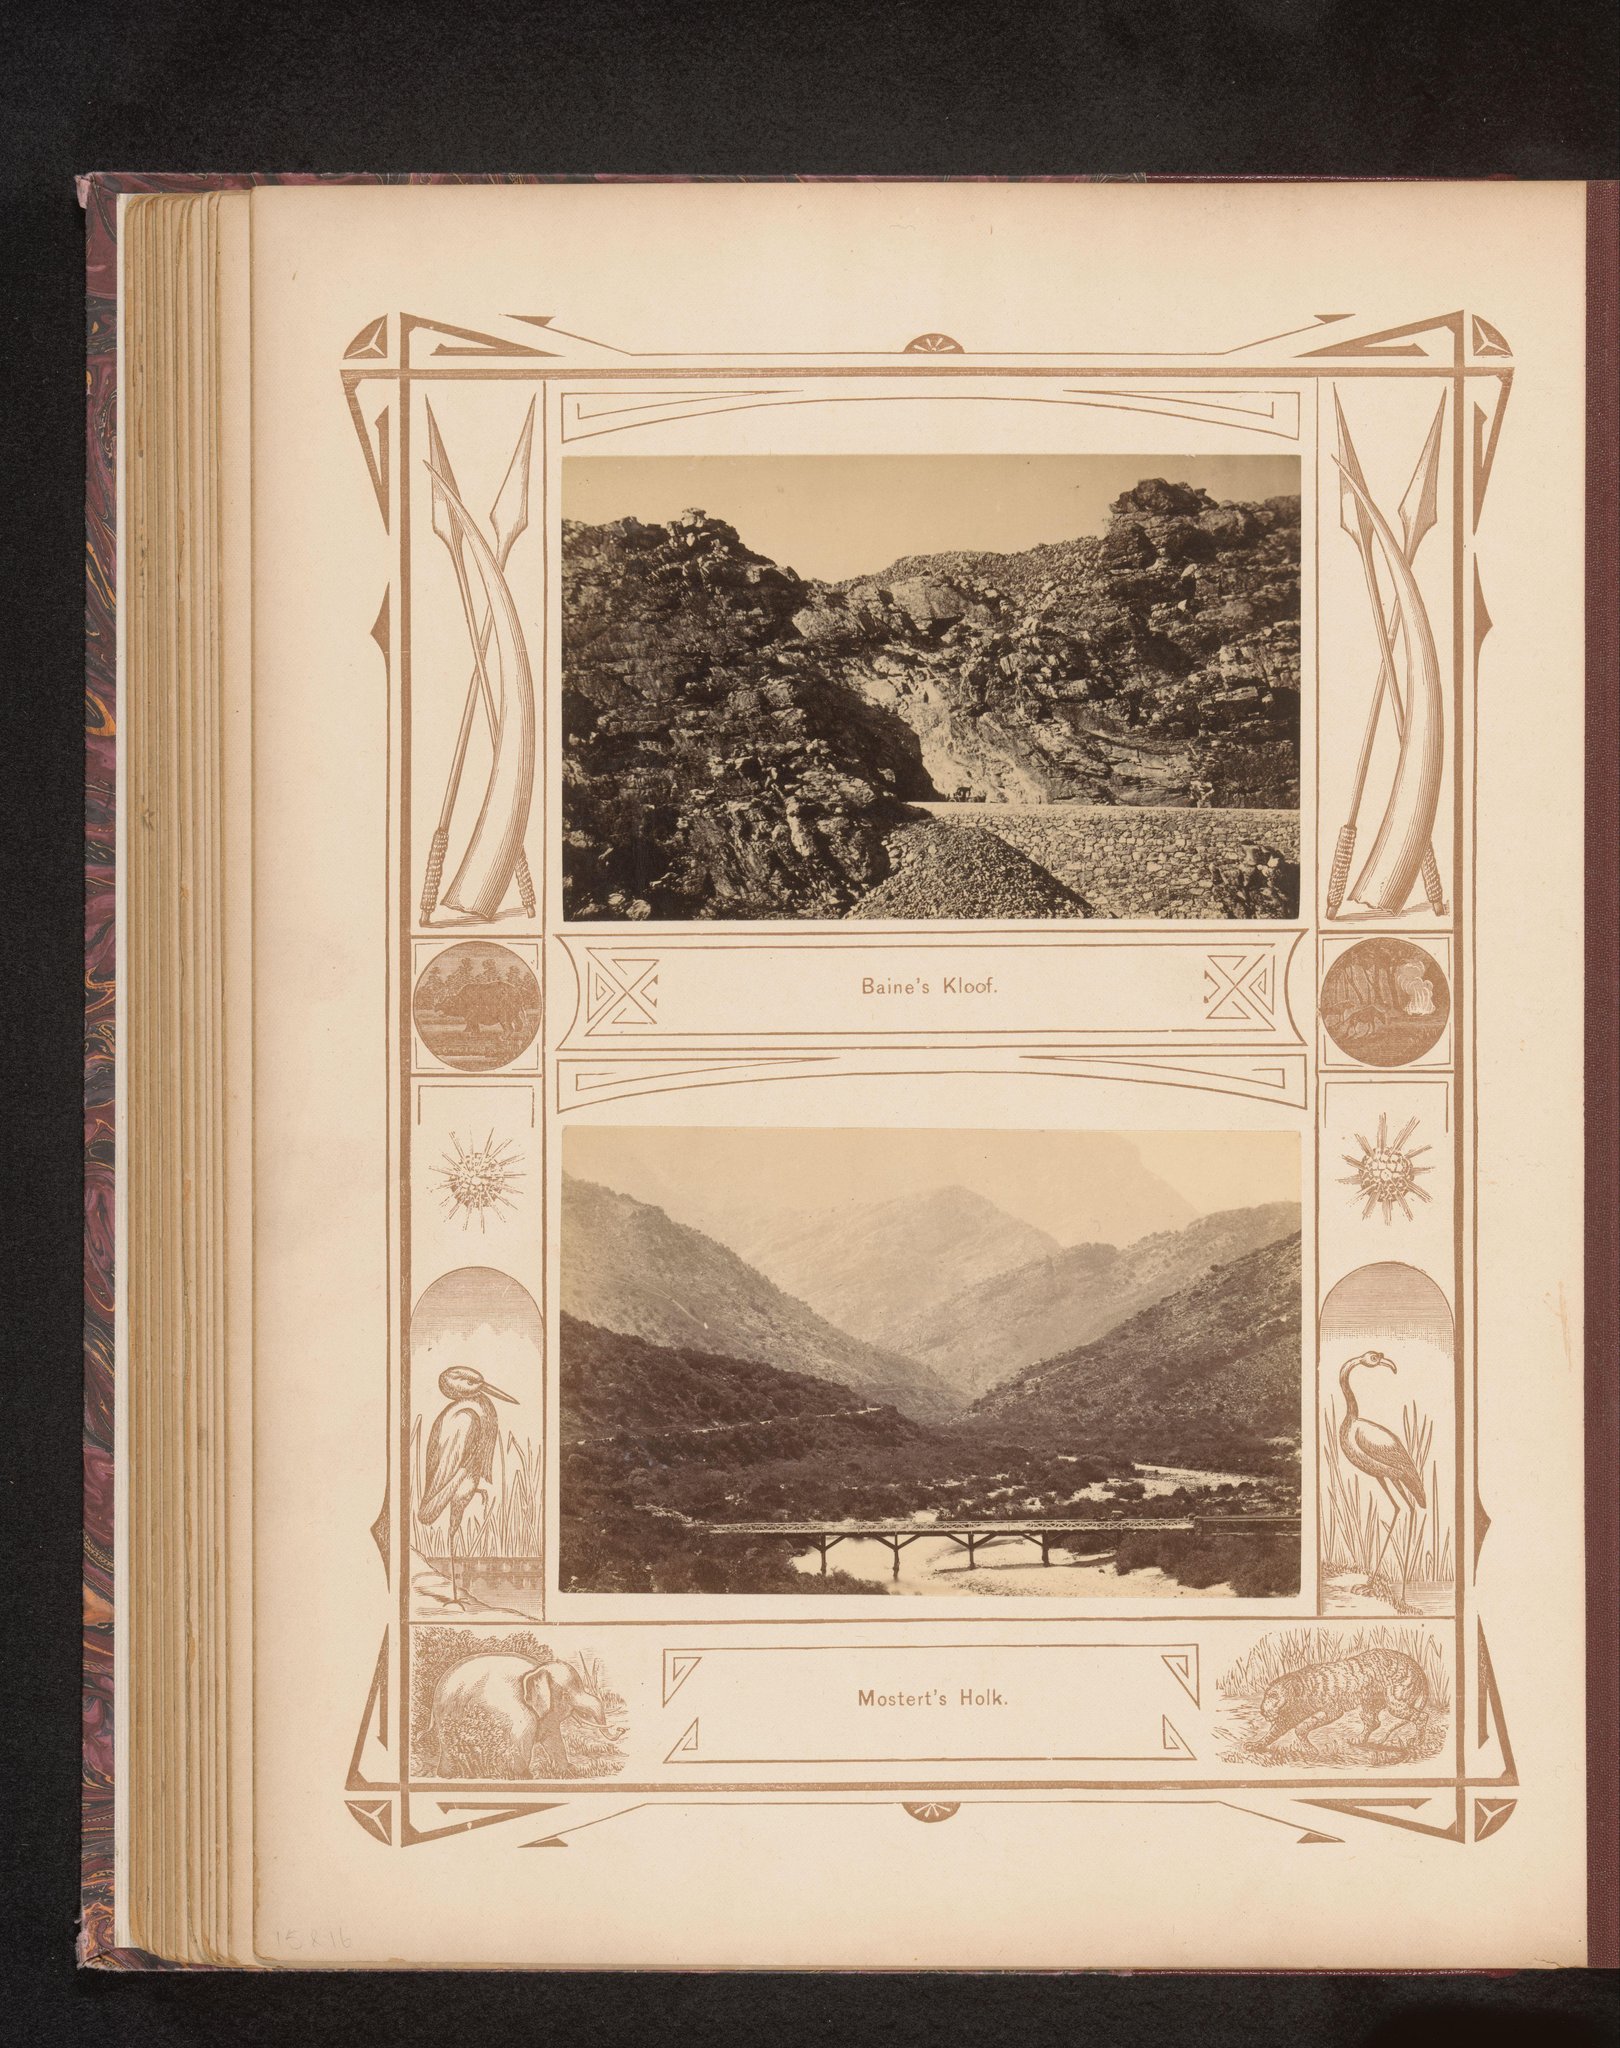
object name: page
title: Gezicht op een rivier tussen de bergen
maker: Anonymous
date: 1877-1882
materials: photographic support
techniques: albumen print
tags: river, landscape with bridge, viaduct or aqueduct, mountains